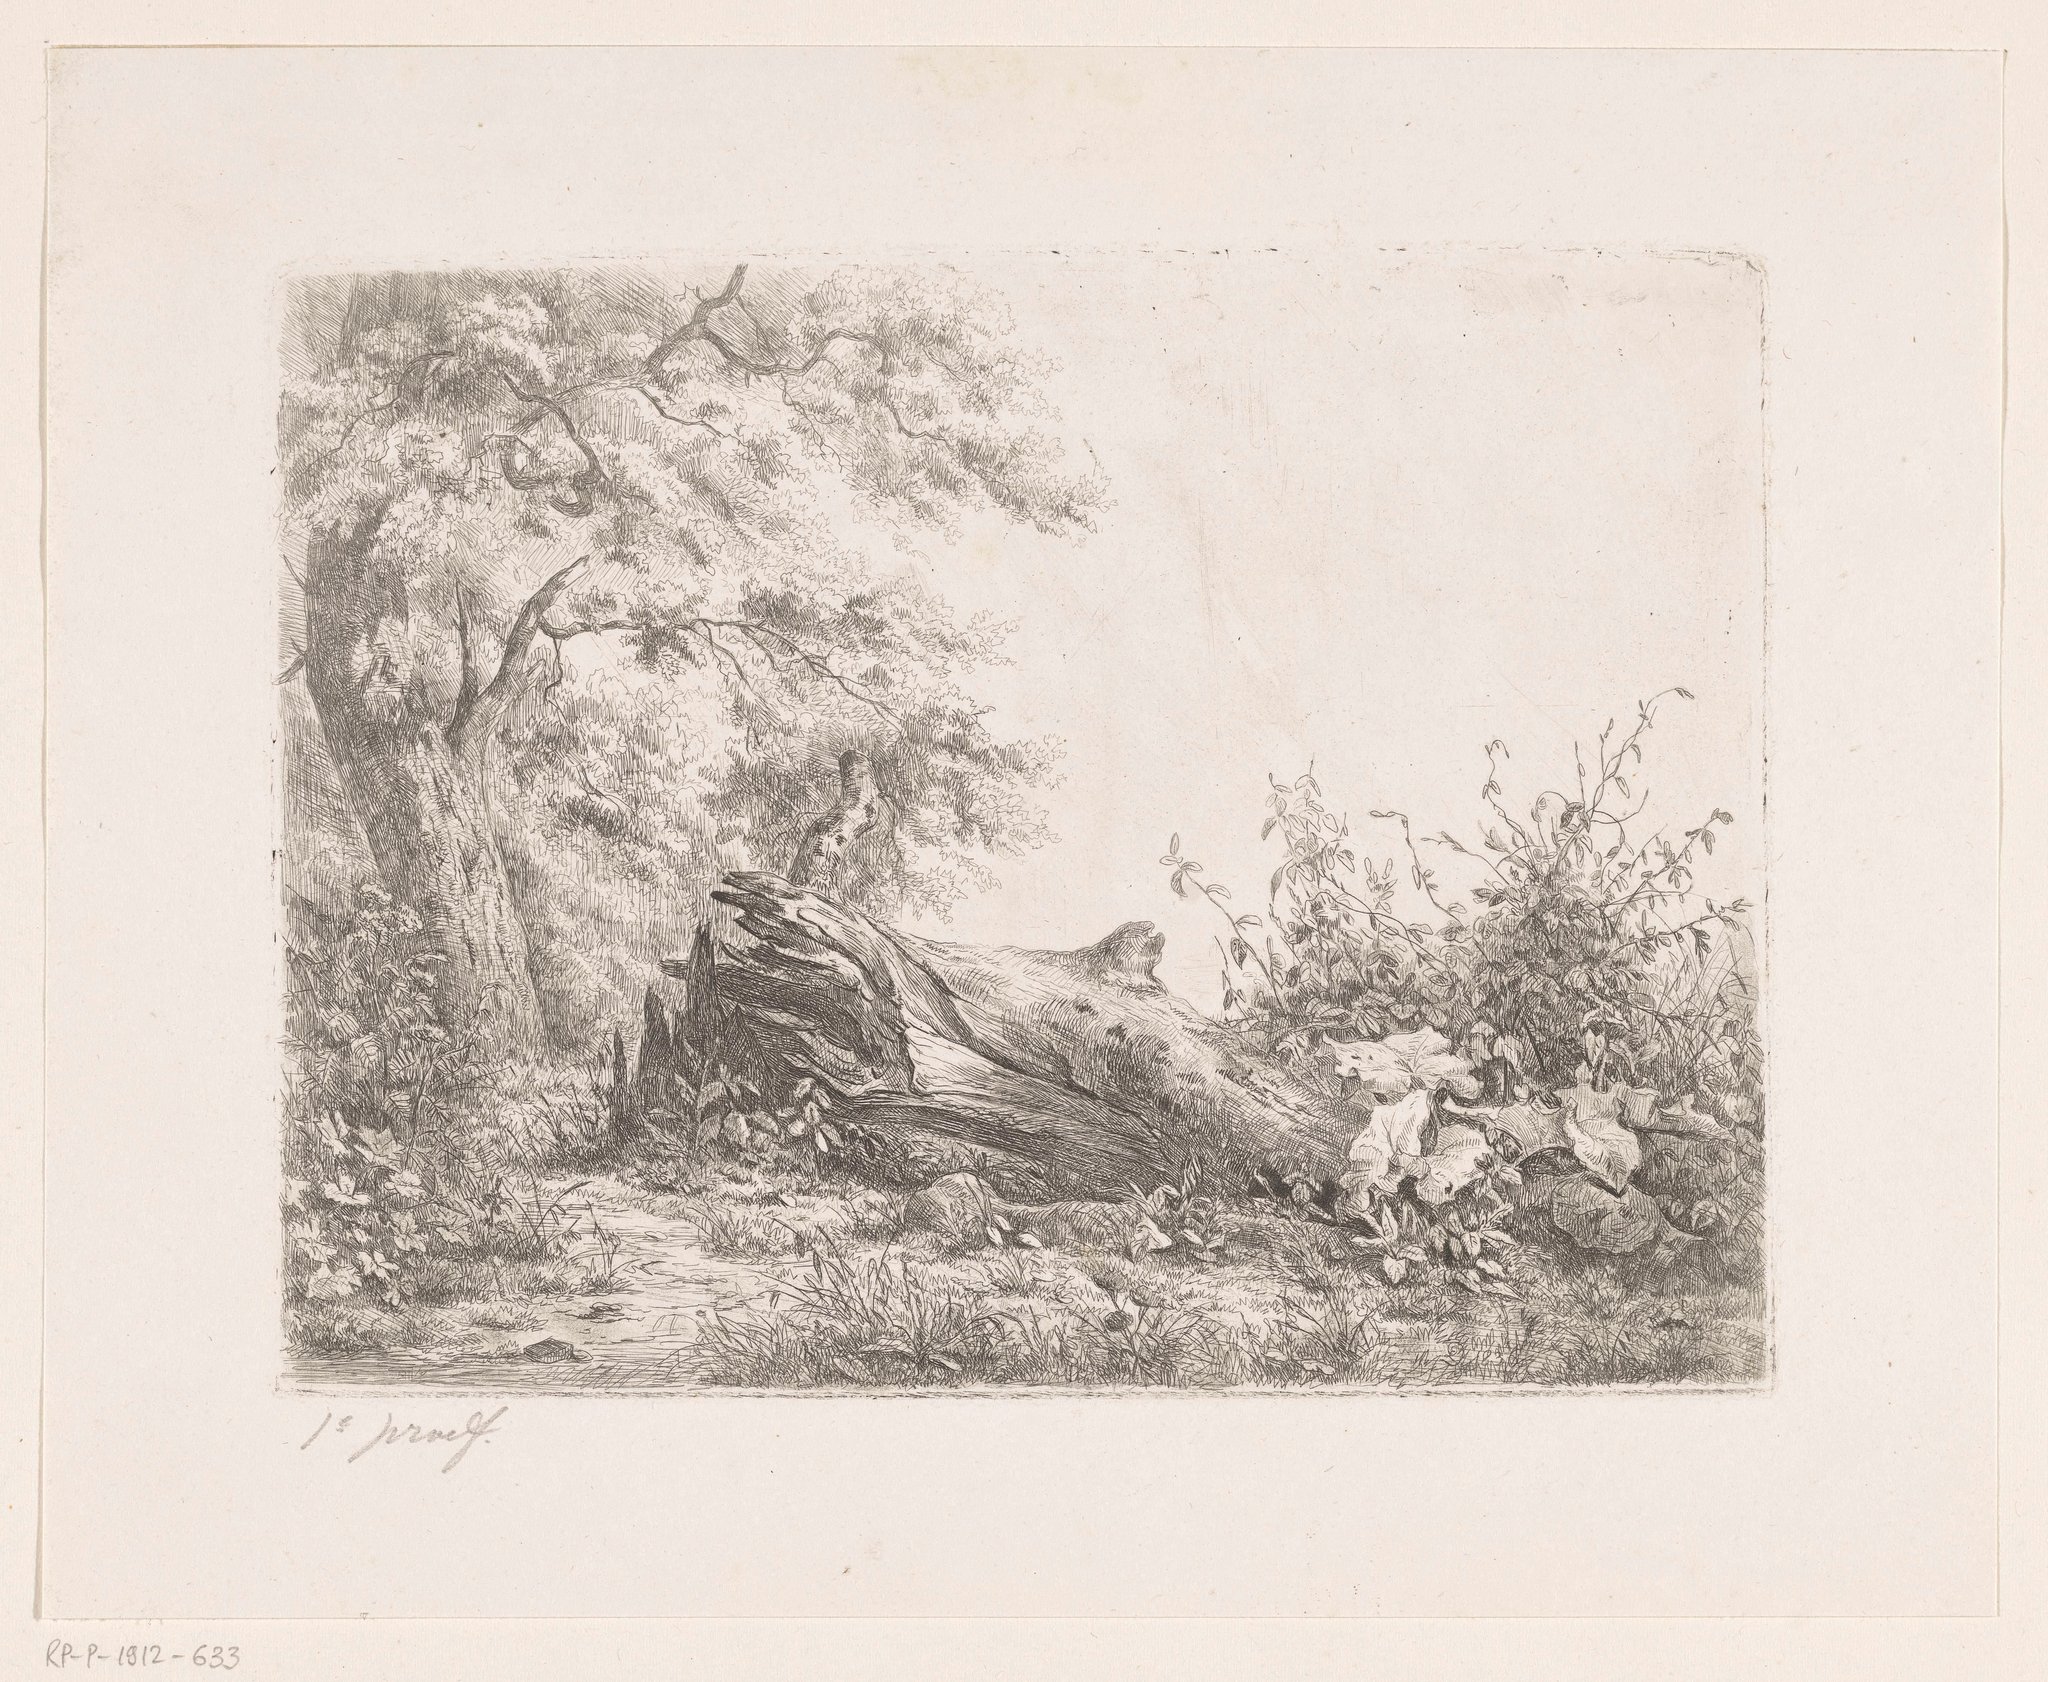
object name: print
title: Vijf etsproeven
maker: pierre louis dubourcq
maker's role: draughtsman, painter, print maker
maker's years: 1815-1873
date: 1836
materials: paper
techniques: etching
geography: netherlands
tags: trees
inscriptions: collector's mark: Lugt 2228